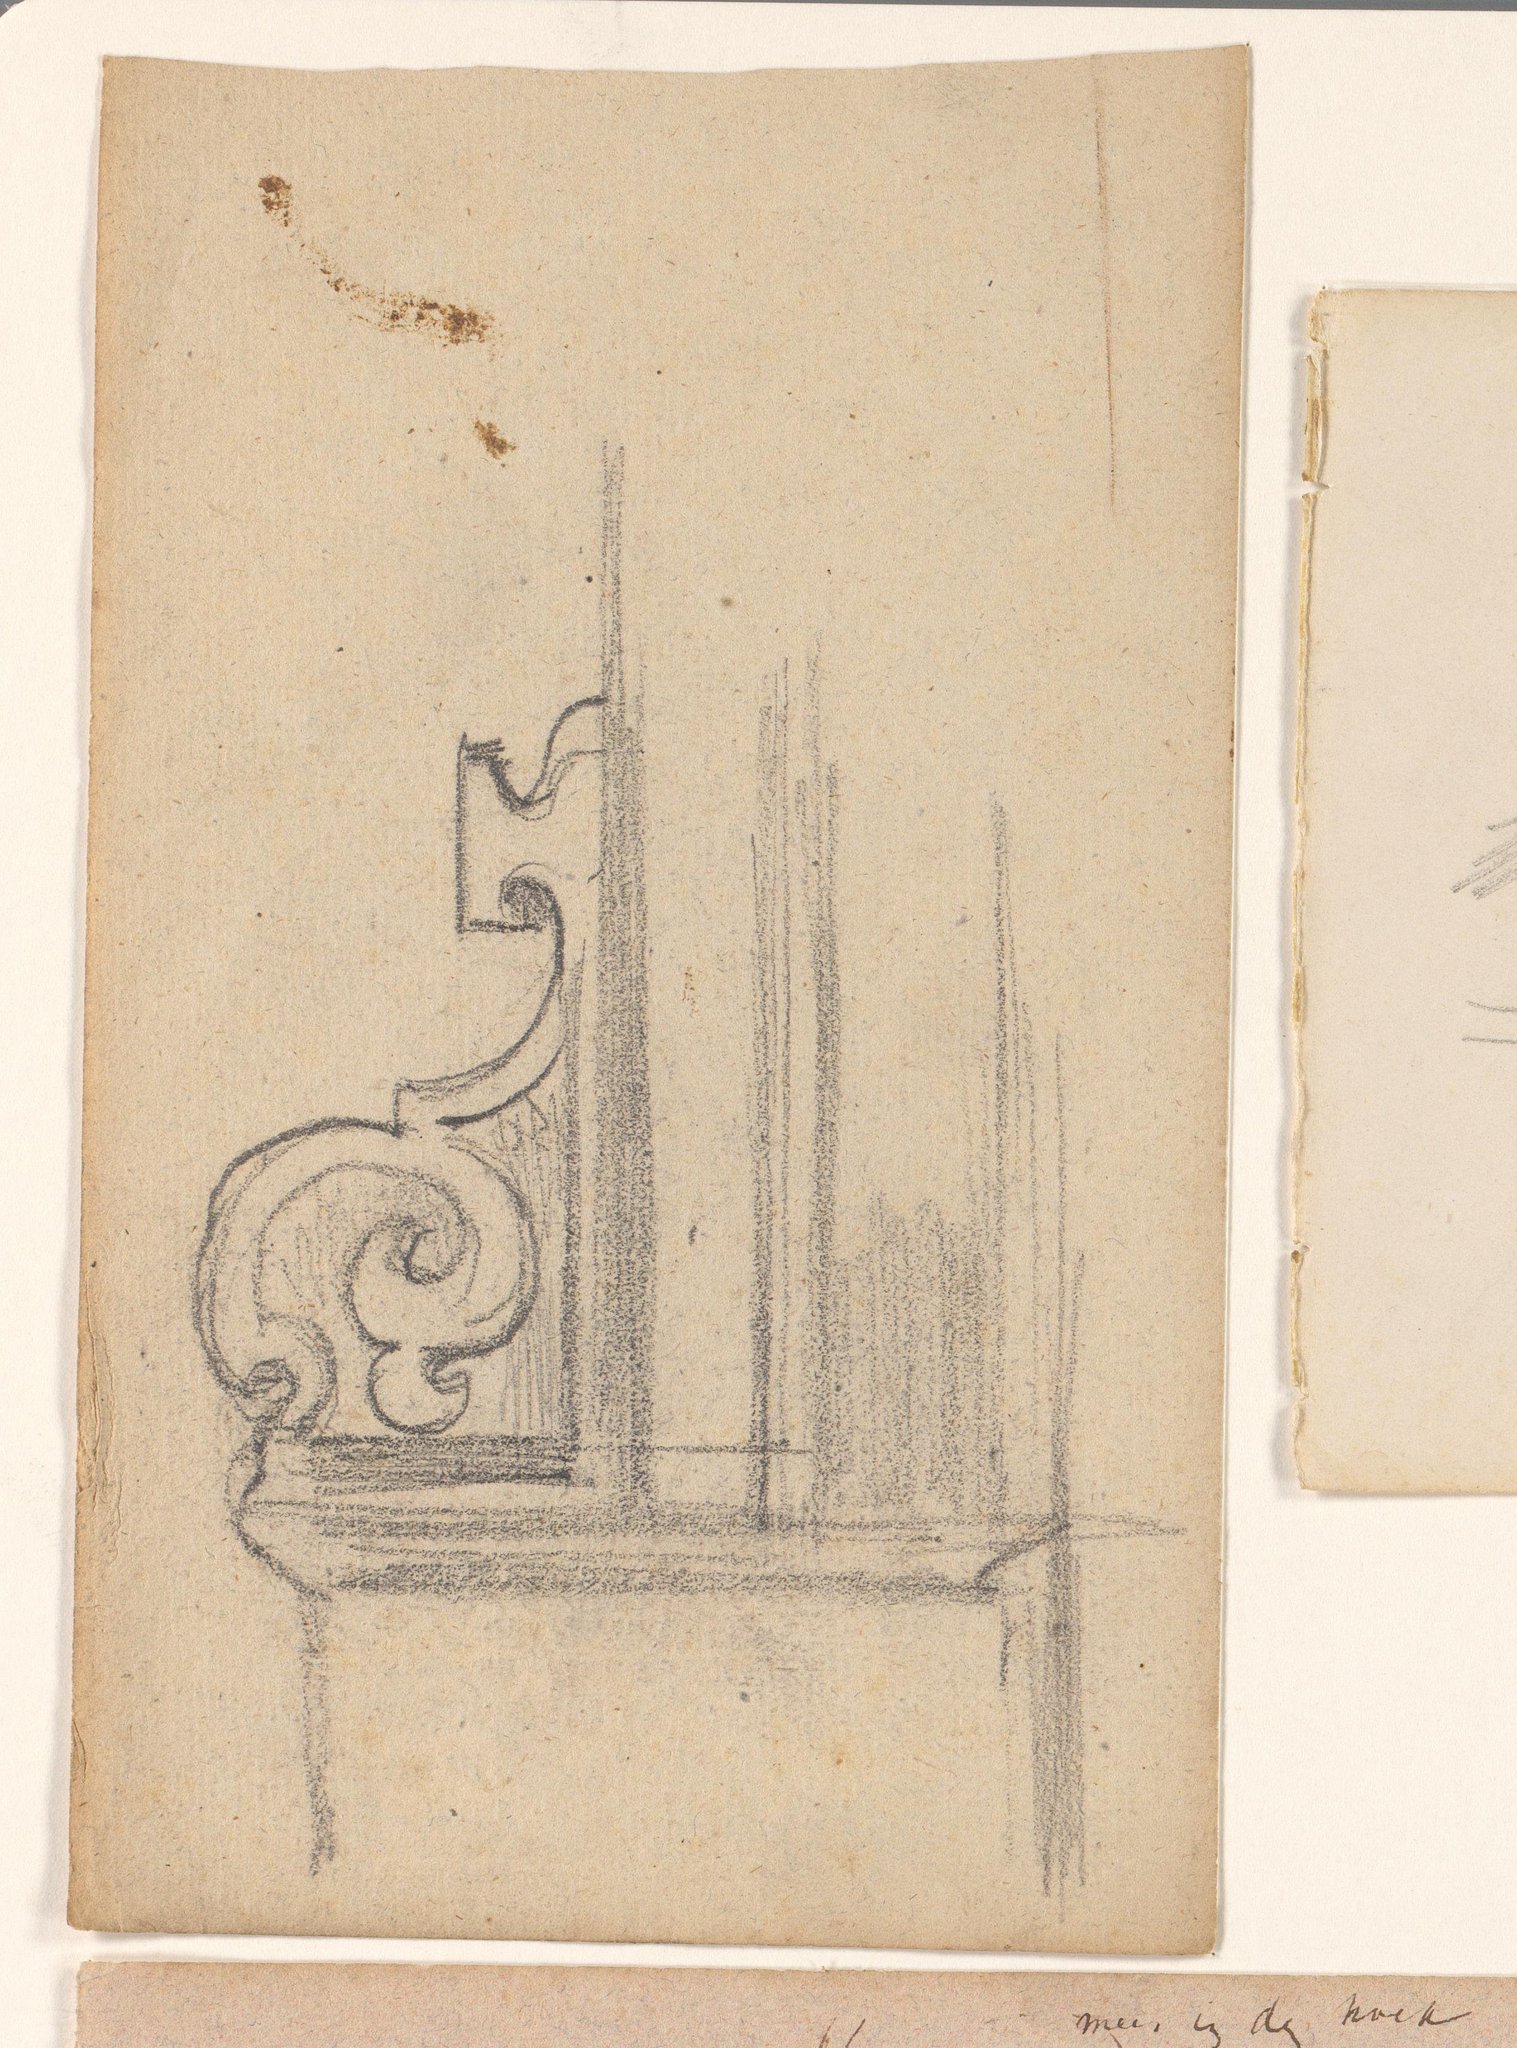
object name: drawing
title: Schetsblad met architectuurstudie, een console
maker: august allebé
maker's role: draughtsman, print maker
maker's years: 1838-1927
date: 1848-1927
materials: chalk, paper